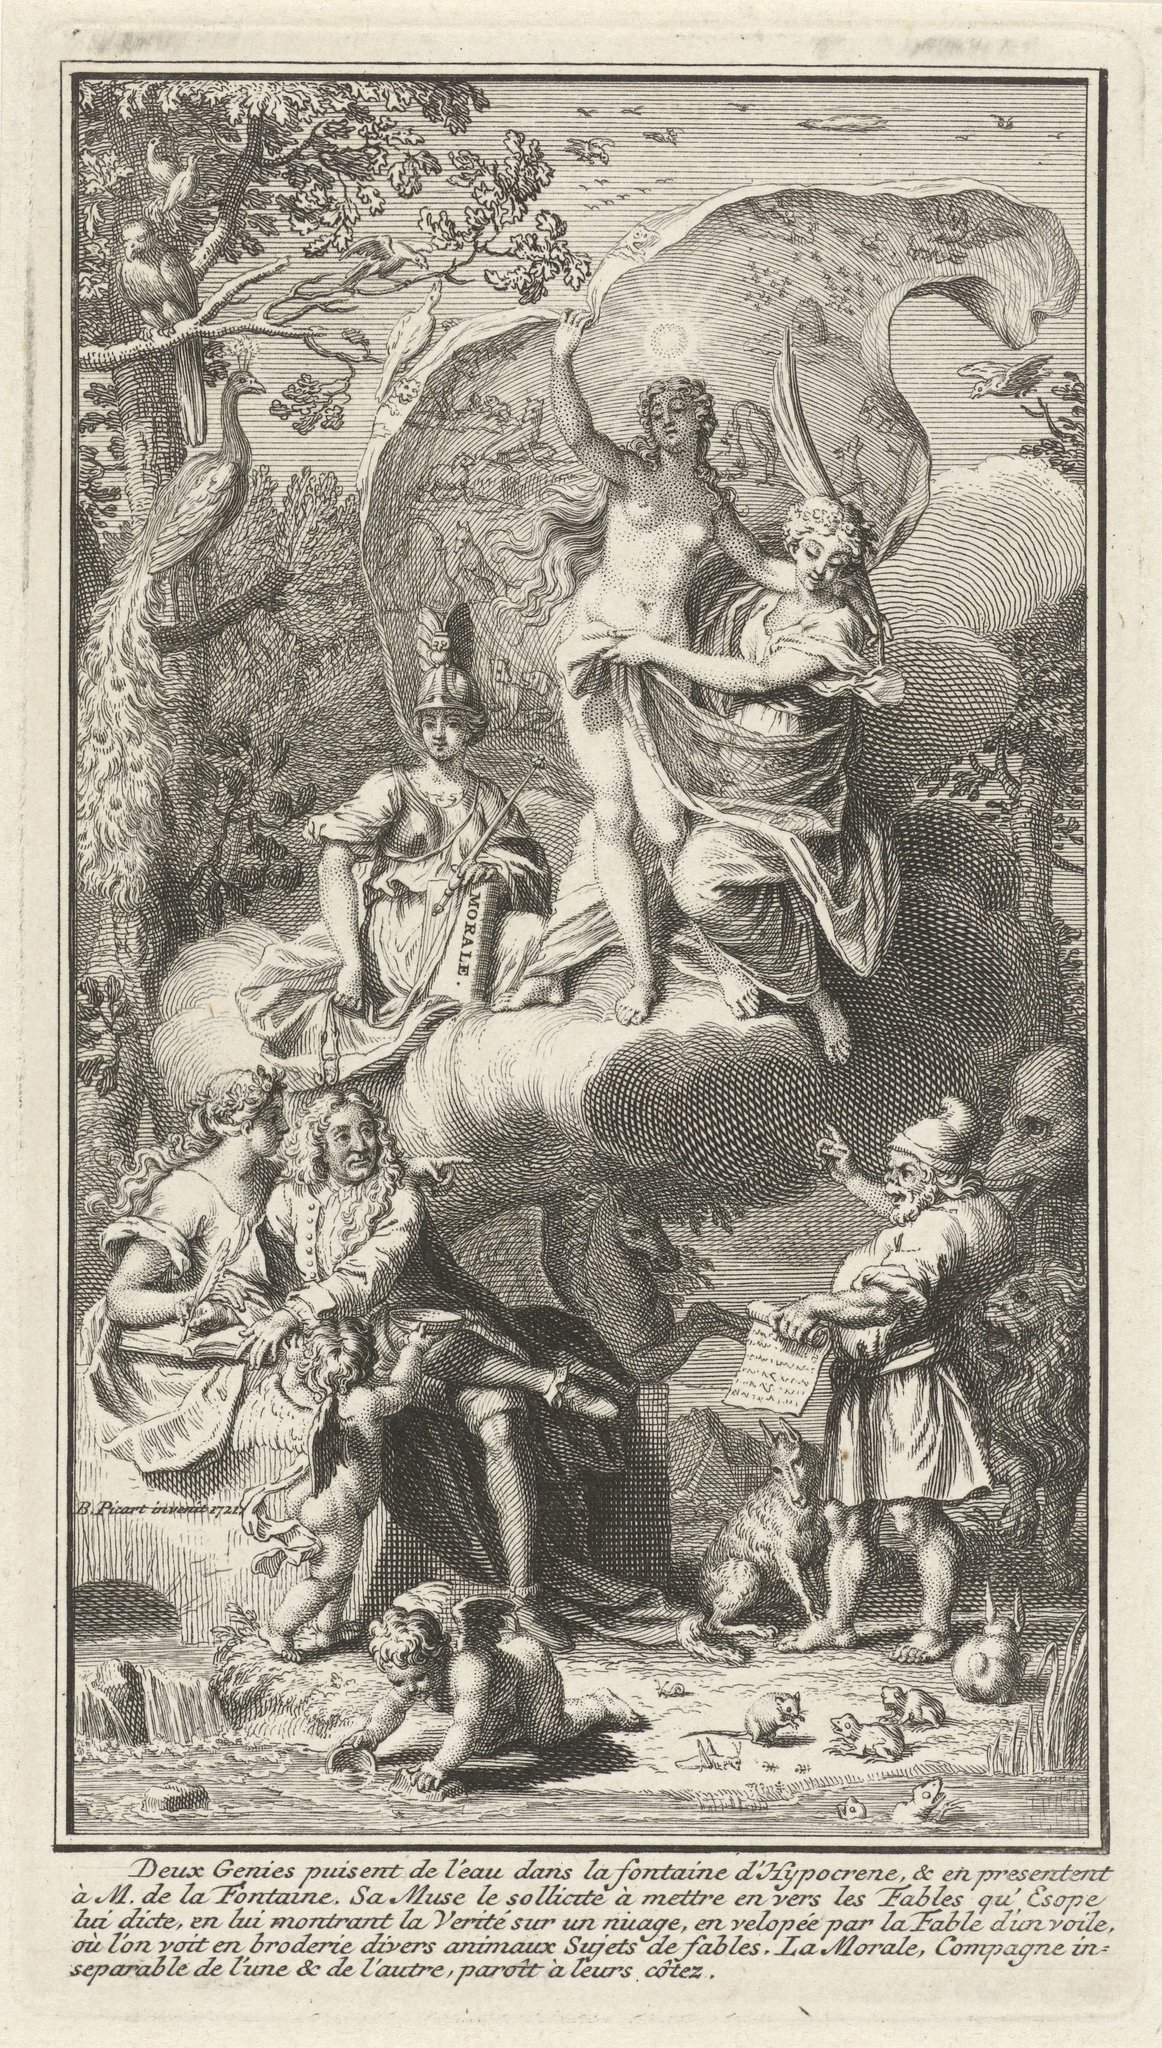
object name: print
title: Allegorische titelpagina met de schrijver Jean de La Fontaine en zijn muze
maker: bernard picart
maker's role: draughtsman, print maker, publisher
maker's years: 1673-1733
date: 1721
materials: paper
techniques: engraving, etching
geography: amsterdam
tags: paris, jean de la fontaine, aesopus, the poet and his muse, pegasus, the winged horse, fables (+ variant), truth; 'verità' (ripa), inspiration of the poet; 'furore poetico' (ripa), hippocrene (fountain of mount helicon), produced when pegasus' hoof struck the ground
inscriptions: collector's mark: Lugt 2228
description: De schrijver Jean de La Fontaine schrijft in een boek en wordt vergezeld door zijn muze. Een putto brengt hem een nap met water uit de Hippocrene, de rivier op de berg Helicon en de bron van dichterlijke inspiratie. Hij kijkt naar de Griekse fabelschrijver Aesop die naar de hemel wijst waar op een wolk Waarheid en Fabel staan. Boven hen een doek waarop diverse fabels zijn verbeeld. In de marge een vijfregelig onderschrift in het Frans.